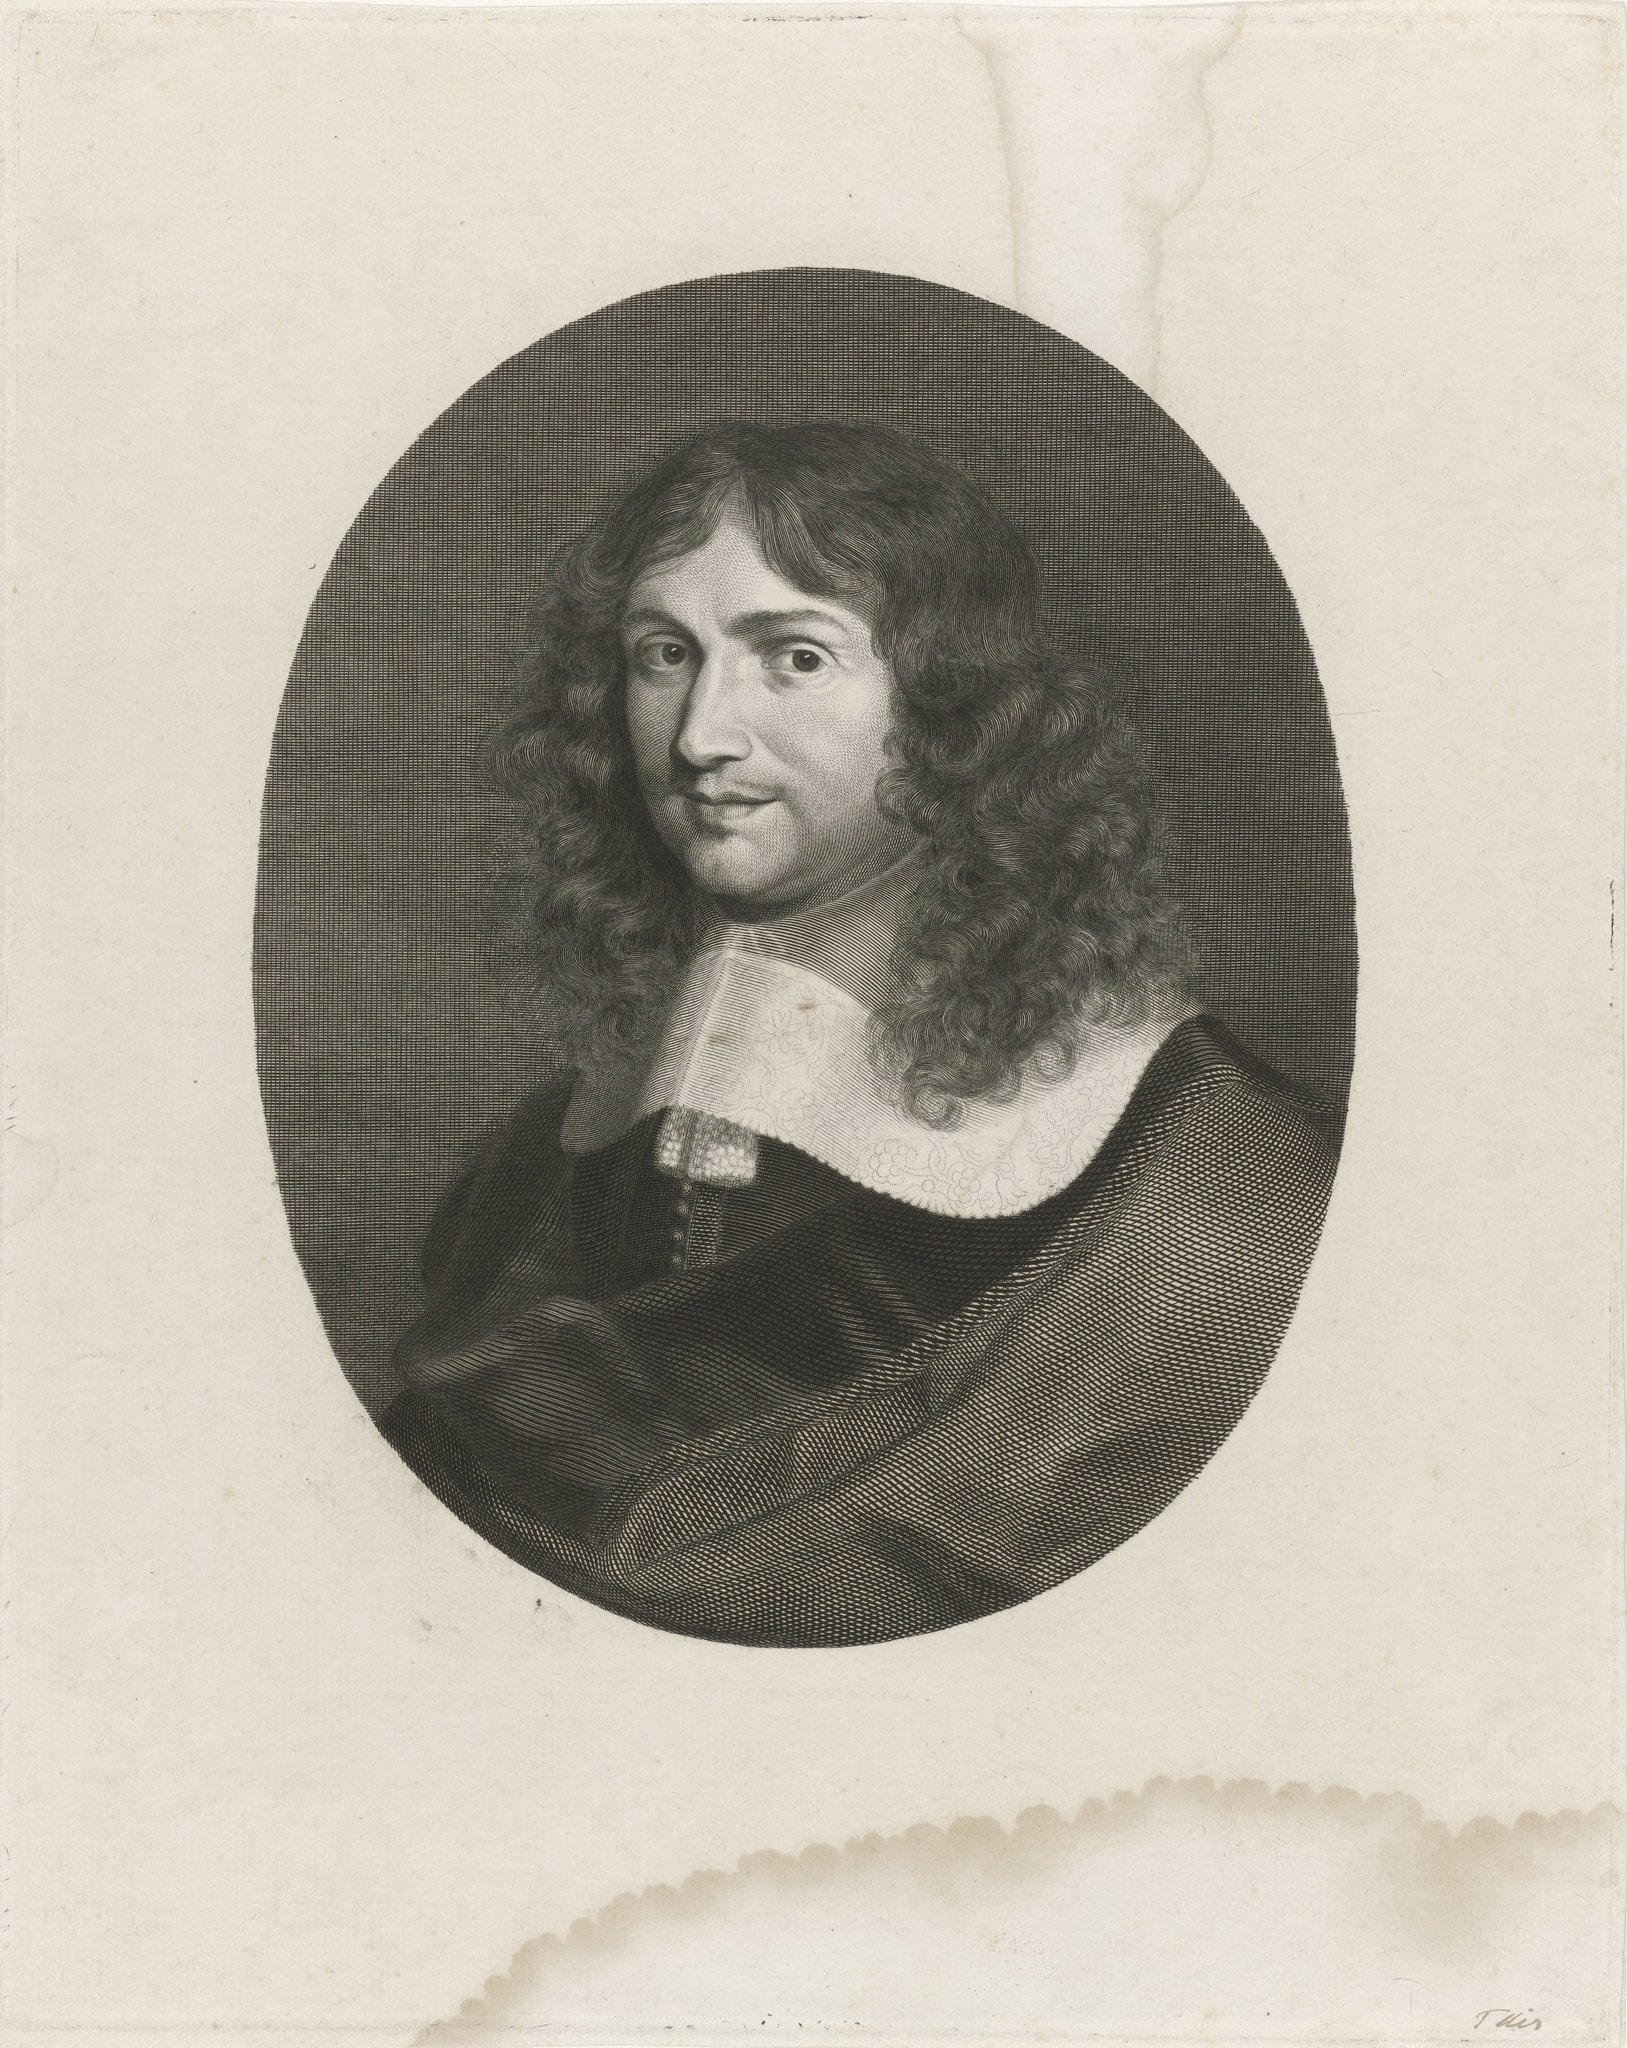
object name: print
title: Portret van een jonge man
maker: pieter romans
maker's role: draughtsman, print maker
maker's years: 1815-1835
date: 1828-1835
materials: paper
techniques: engraving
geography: amsterdam